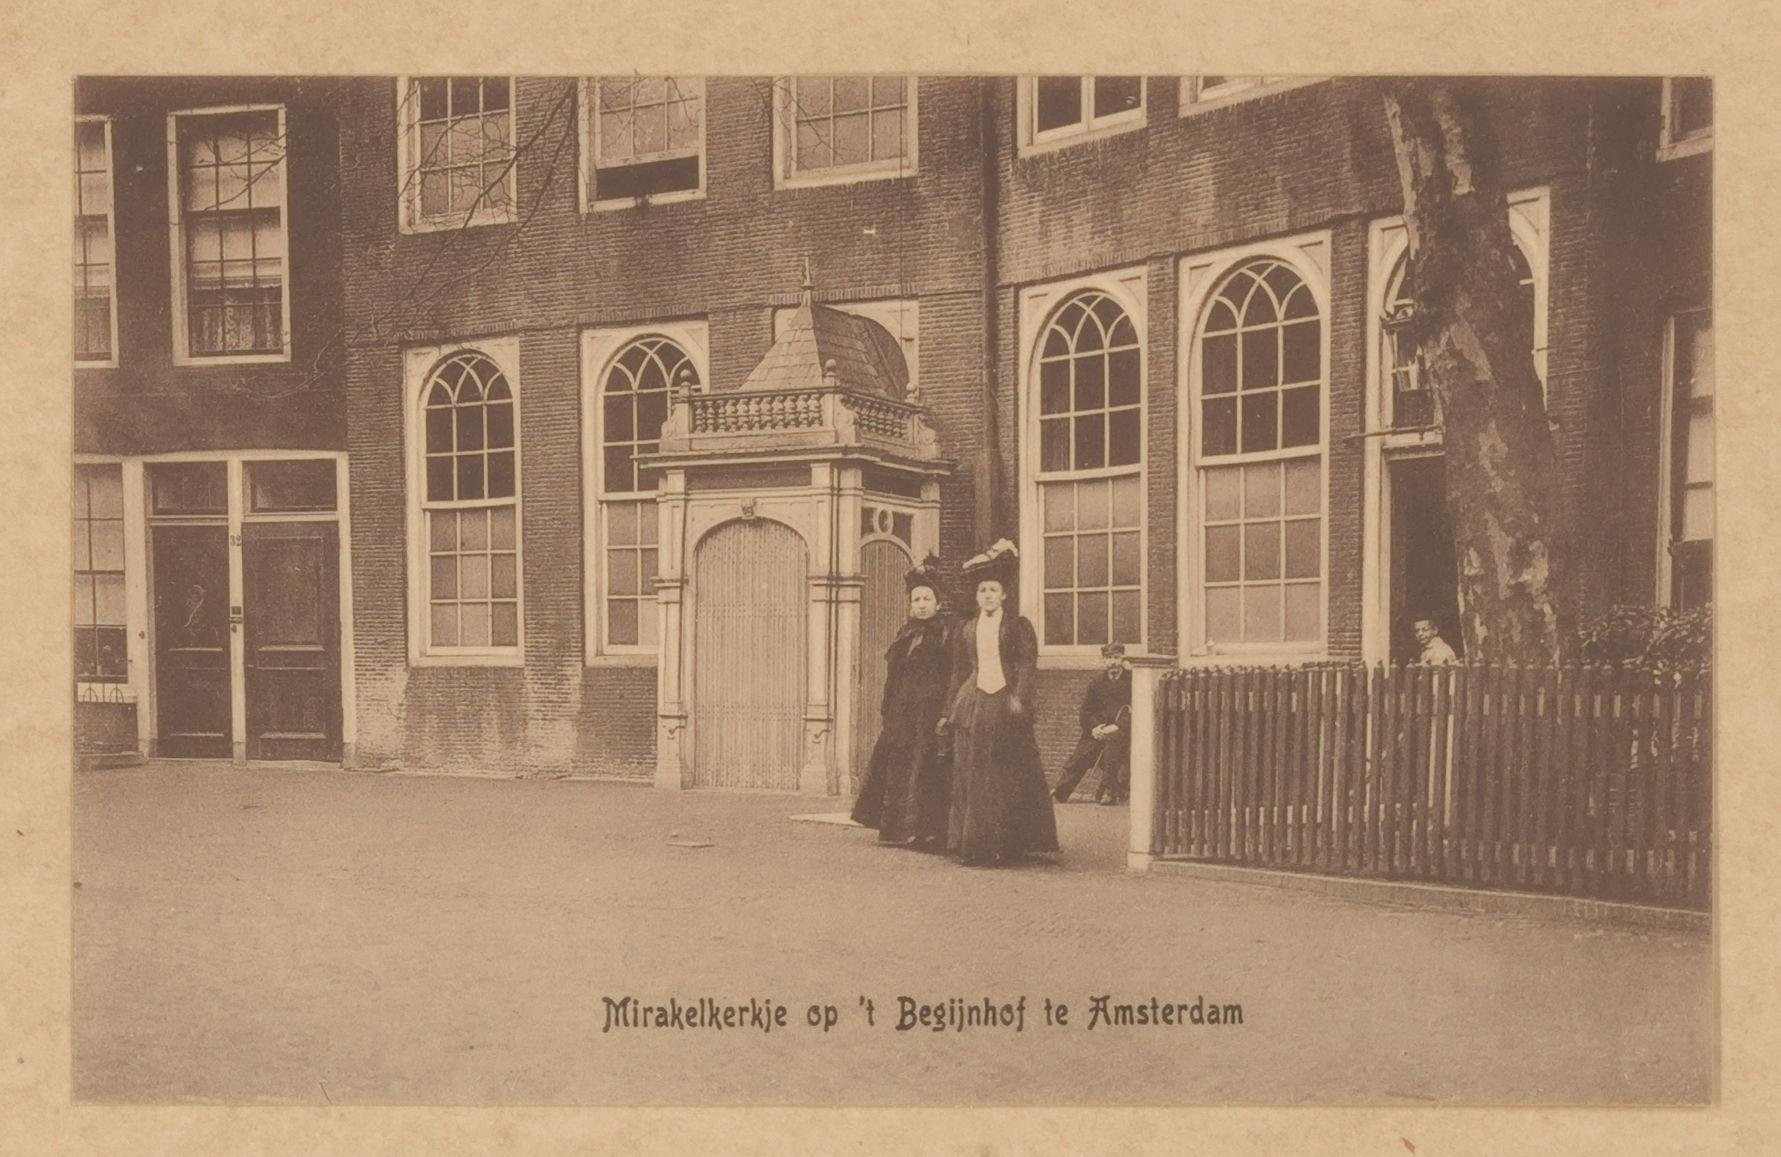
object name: ansichtkaart, prentbriefkaart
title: Gezicht op de Begijnhofkapel te Amsterdam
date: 1905-1919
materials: paper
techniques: photograph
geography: amsterdam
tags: church (exterior), street (+ city(-scape) with figures, staffage)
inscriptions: collector's mark: Lugt 1641b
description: Onderwerpsrubriek binnen de Atlas Amsterdam: Kerkwezen: R.K. Gemeenten: Begijnhof t/m Petrus en Paulus.